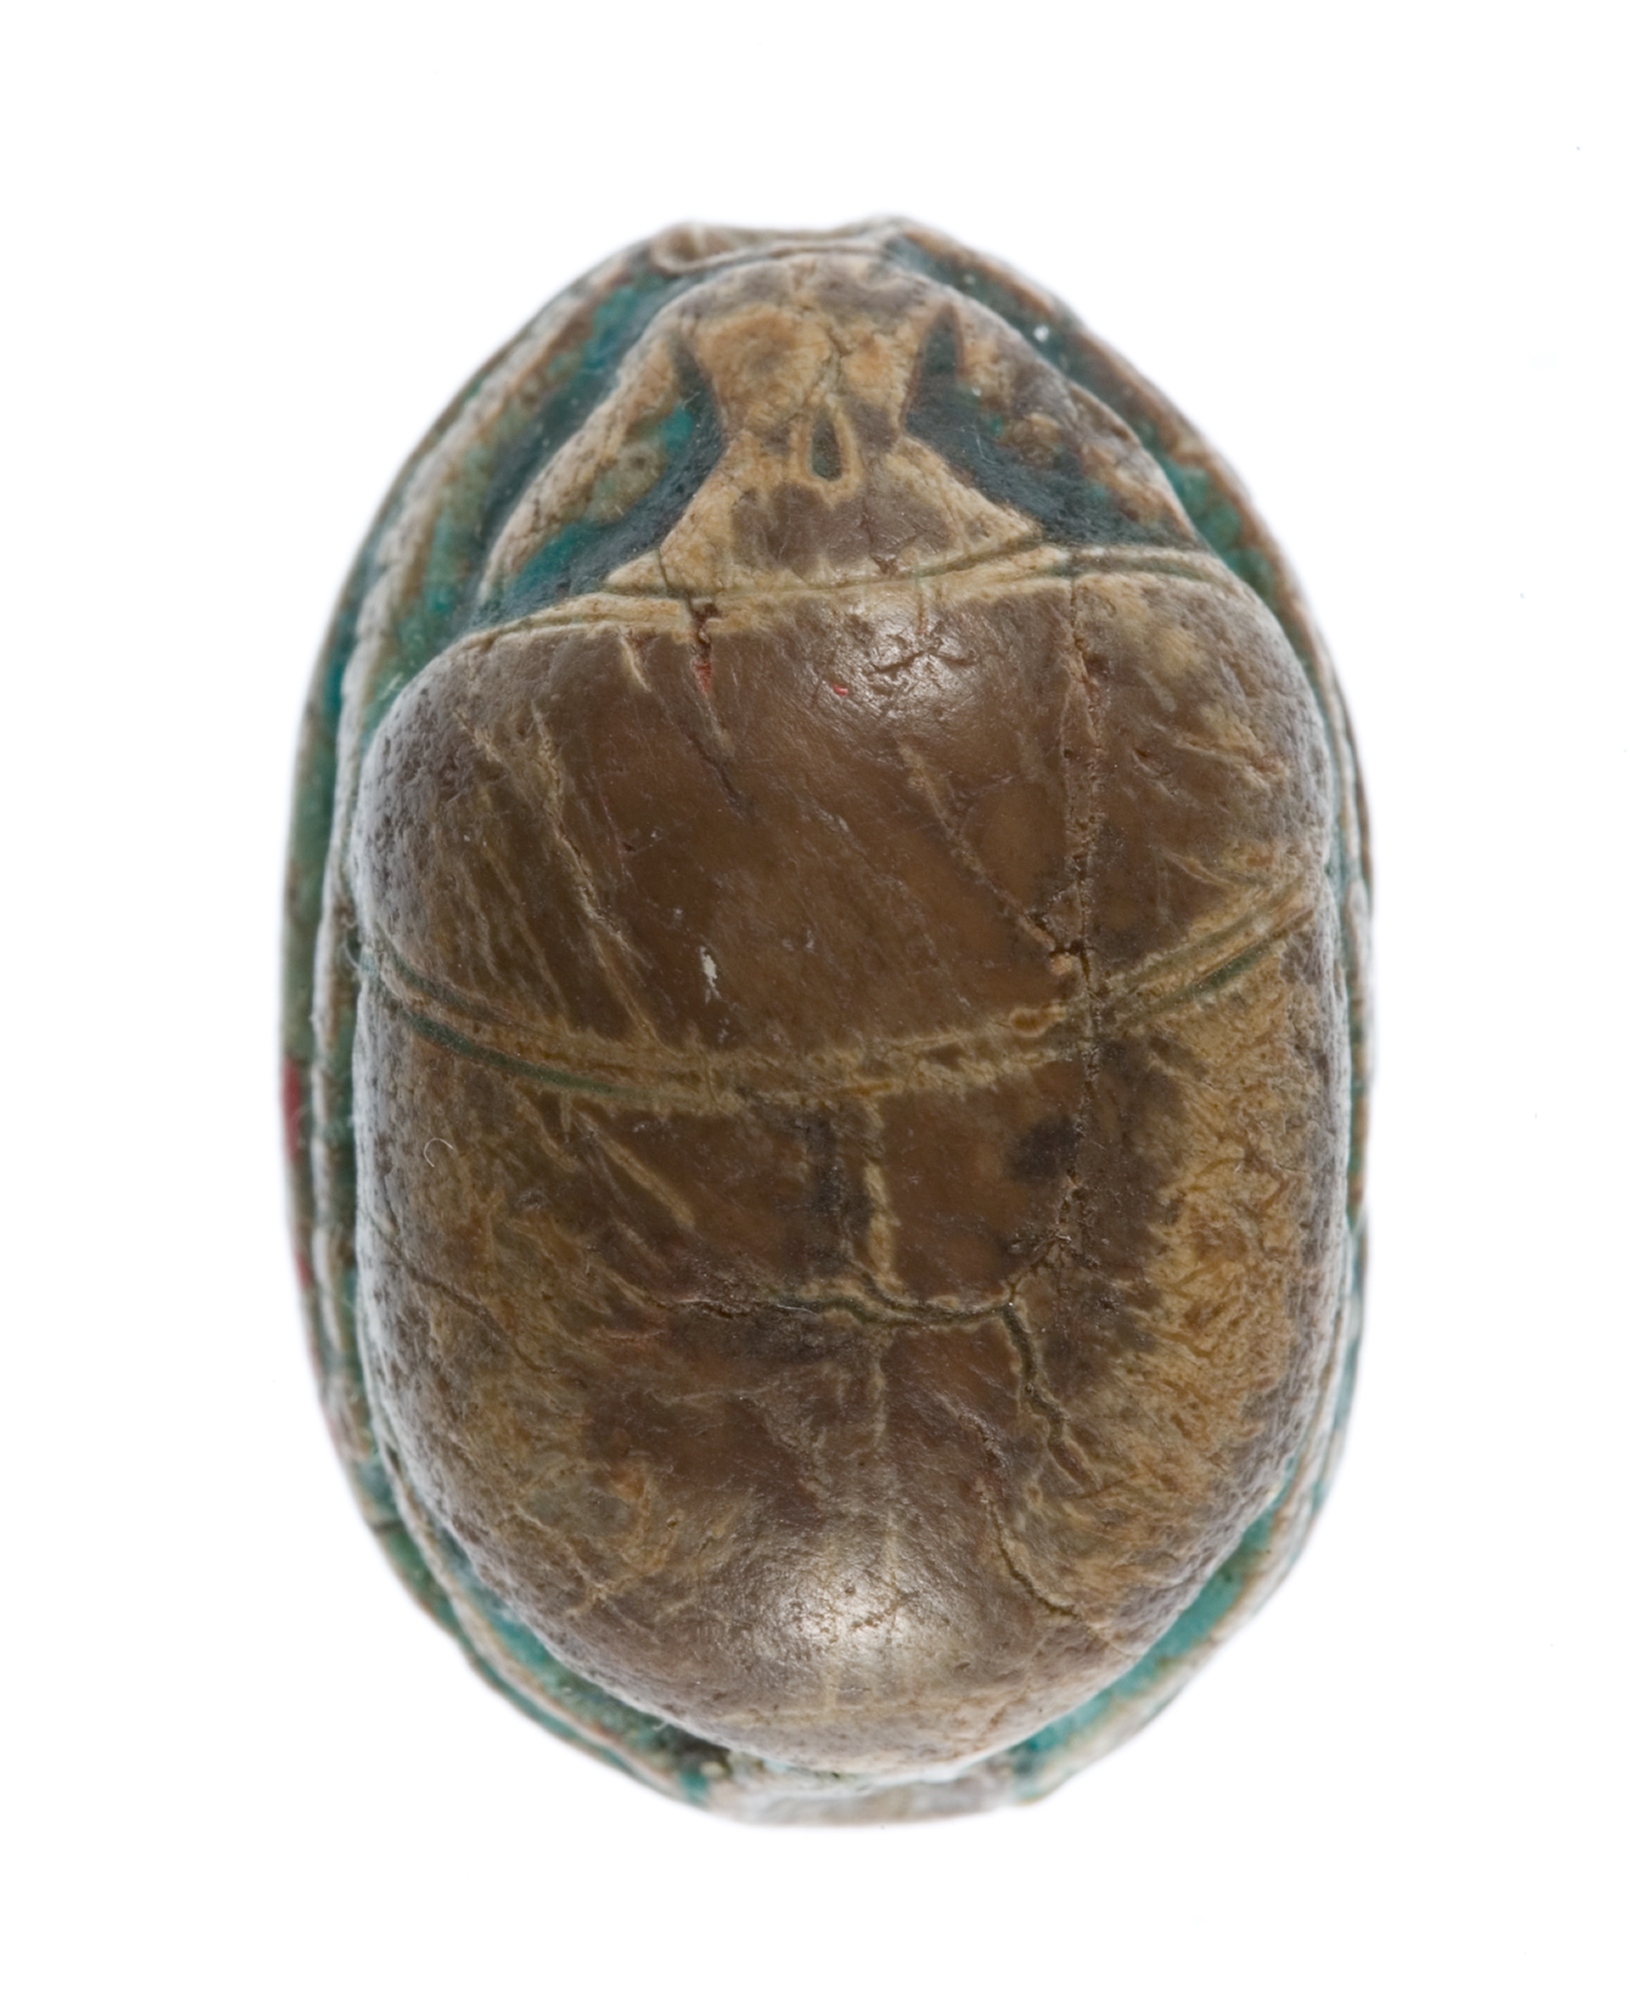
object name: scarab, king sheshi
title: Scarabs with the Name of the Hyksos King Sheshi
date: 1700 BCE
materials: stone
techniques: glazing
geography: egypt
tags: hieroglyphs,scarabs